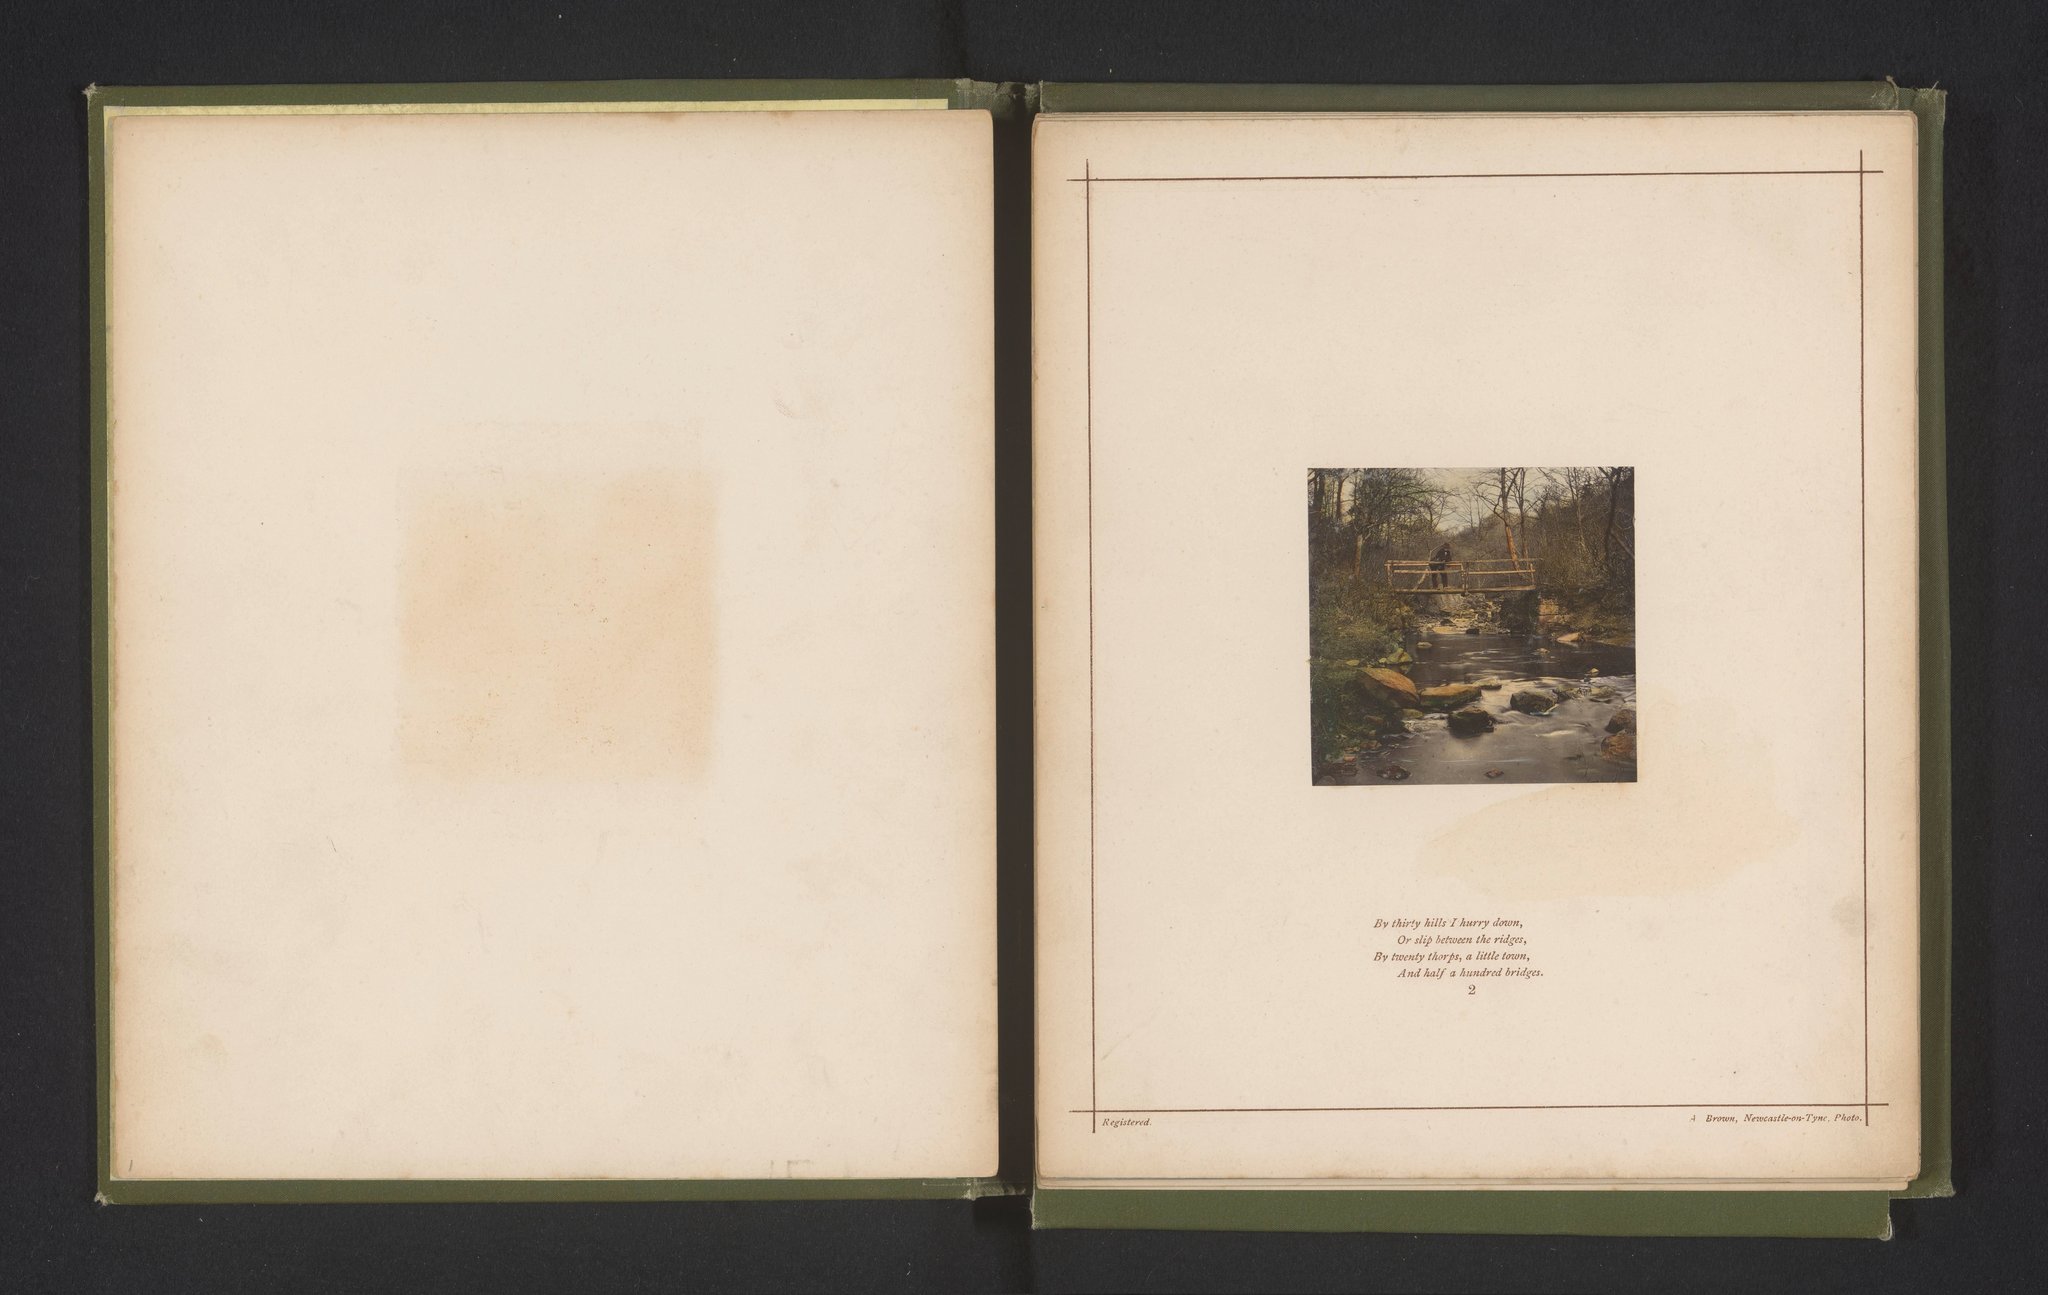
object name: photograph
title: Man op een brug over de beek Skelton Beck nabij Saltburn-by-the-Sea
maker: arthur brown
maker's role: fotograaf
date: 1874-1879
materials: paper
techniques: carbon print, hand coloring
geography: north yorkshire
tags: adult man, brook, bridge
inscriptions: inscription: ‘By thirty hills (...) a hundred bridges.’, number: ‘2’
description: Deze foto maakt deel uit van een omslag met dertien foto's.